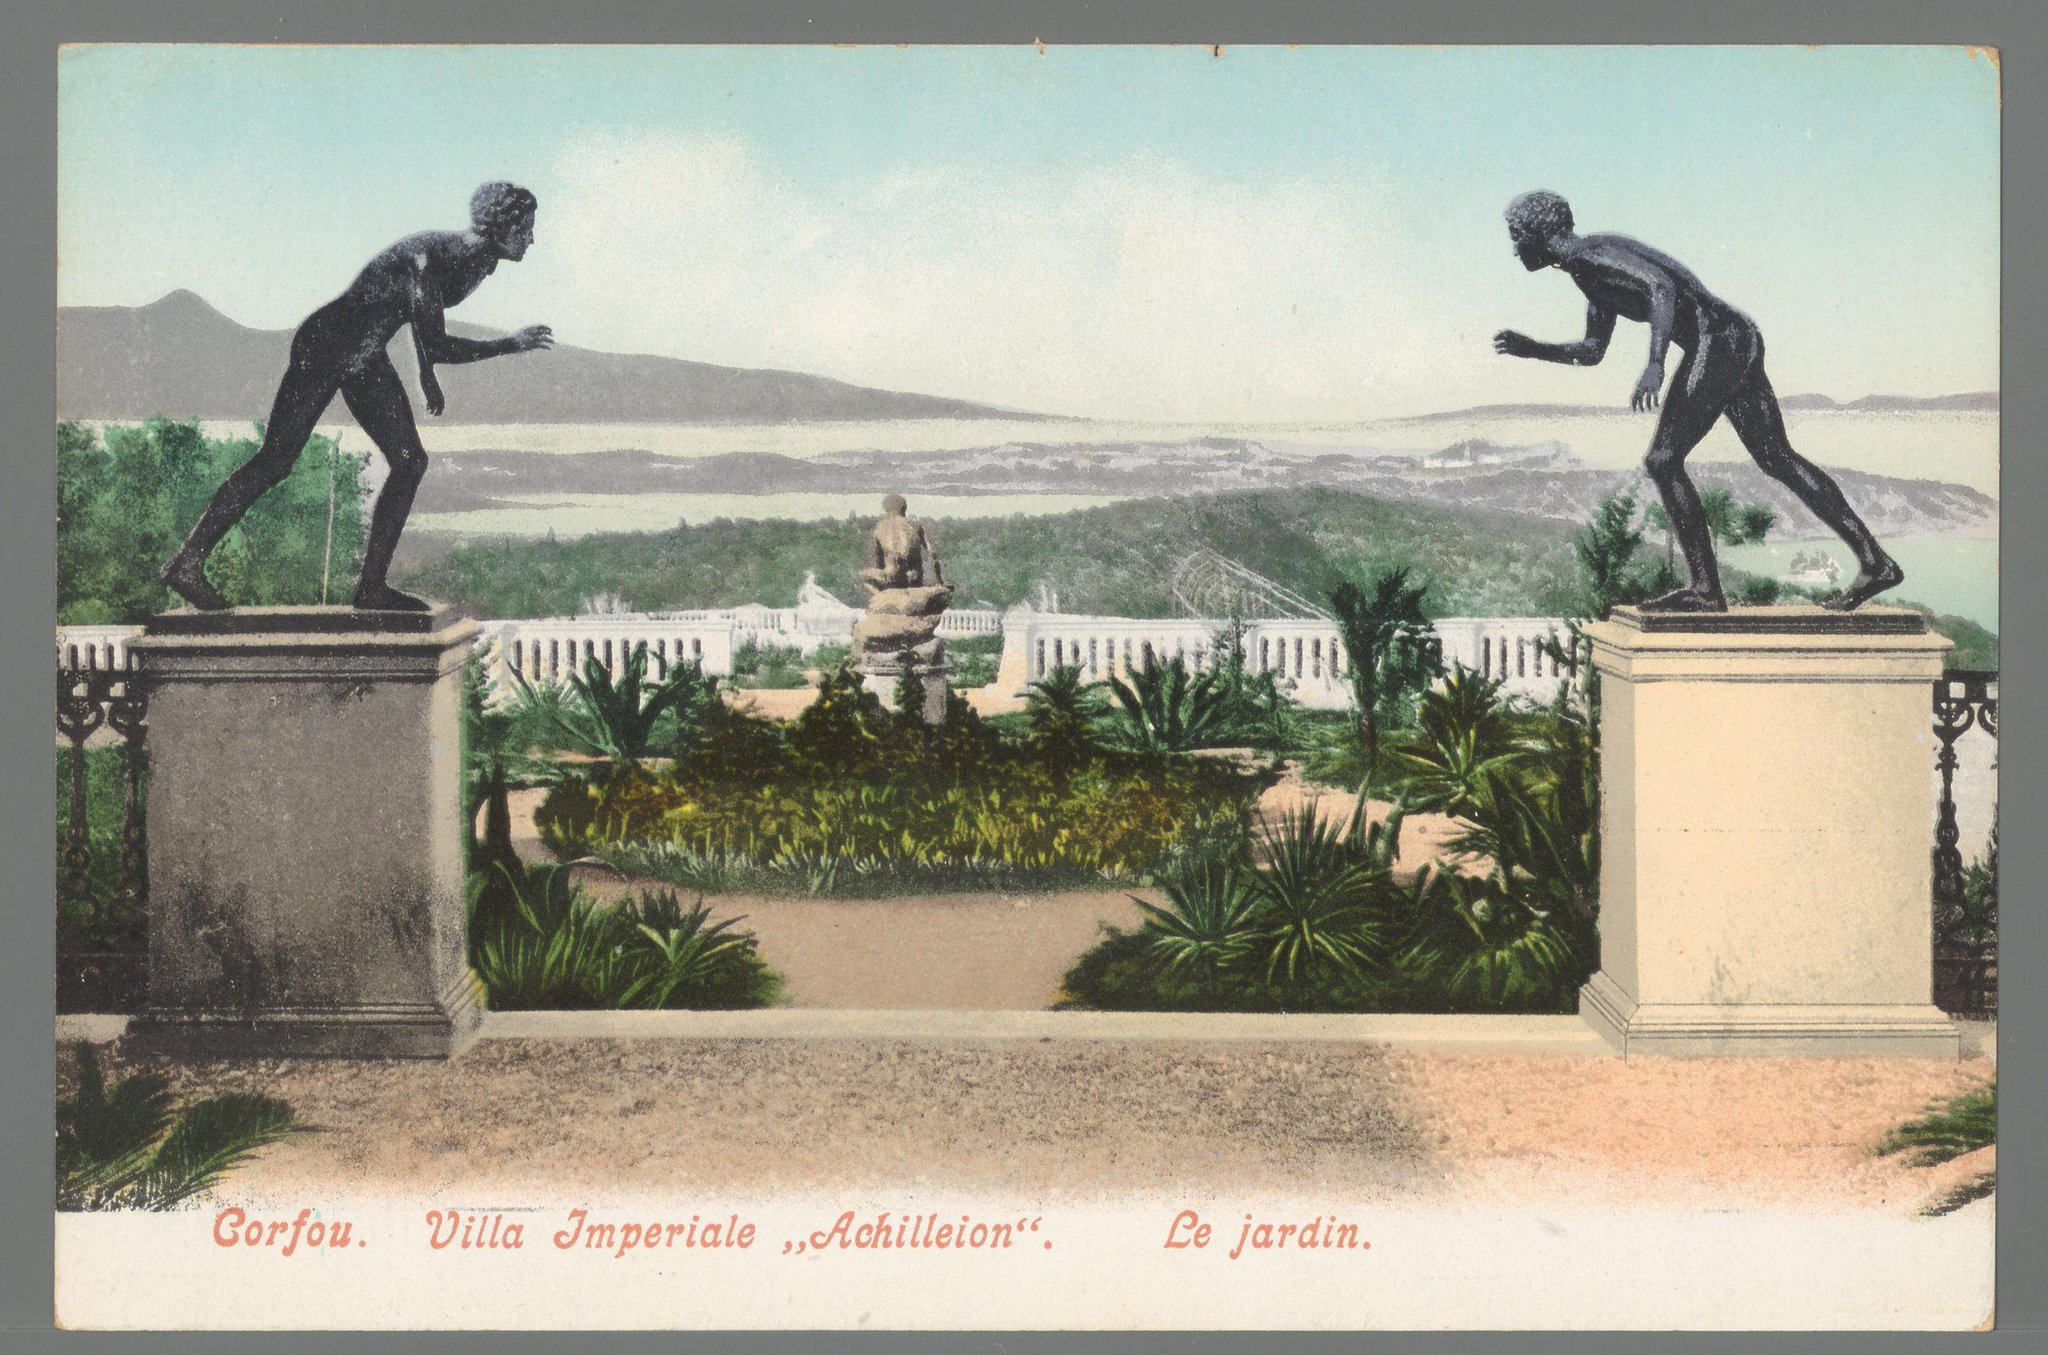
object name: photomechanical print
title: Corfou. Villa Imperiale "Achilleion". Le jardin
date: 1906-1909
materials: cardboard, photographic process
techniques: writing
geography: corfu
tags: garden, palace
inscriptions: monogram: ‘A.A.K. Corfou’